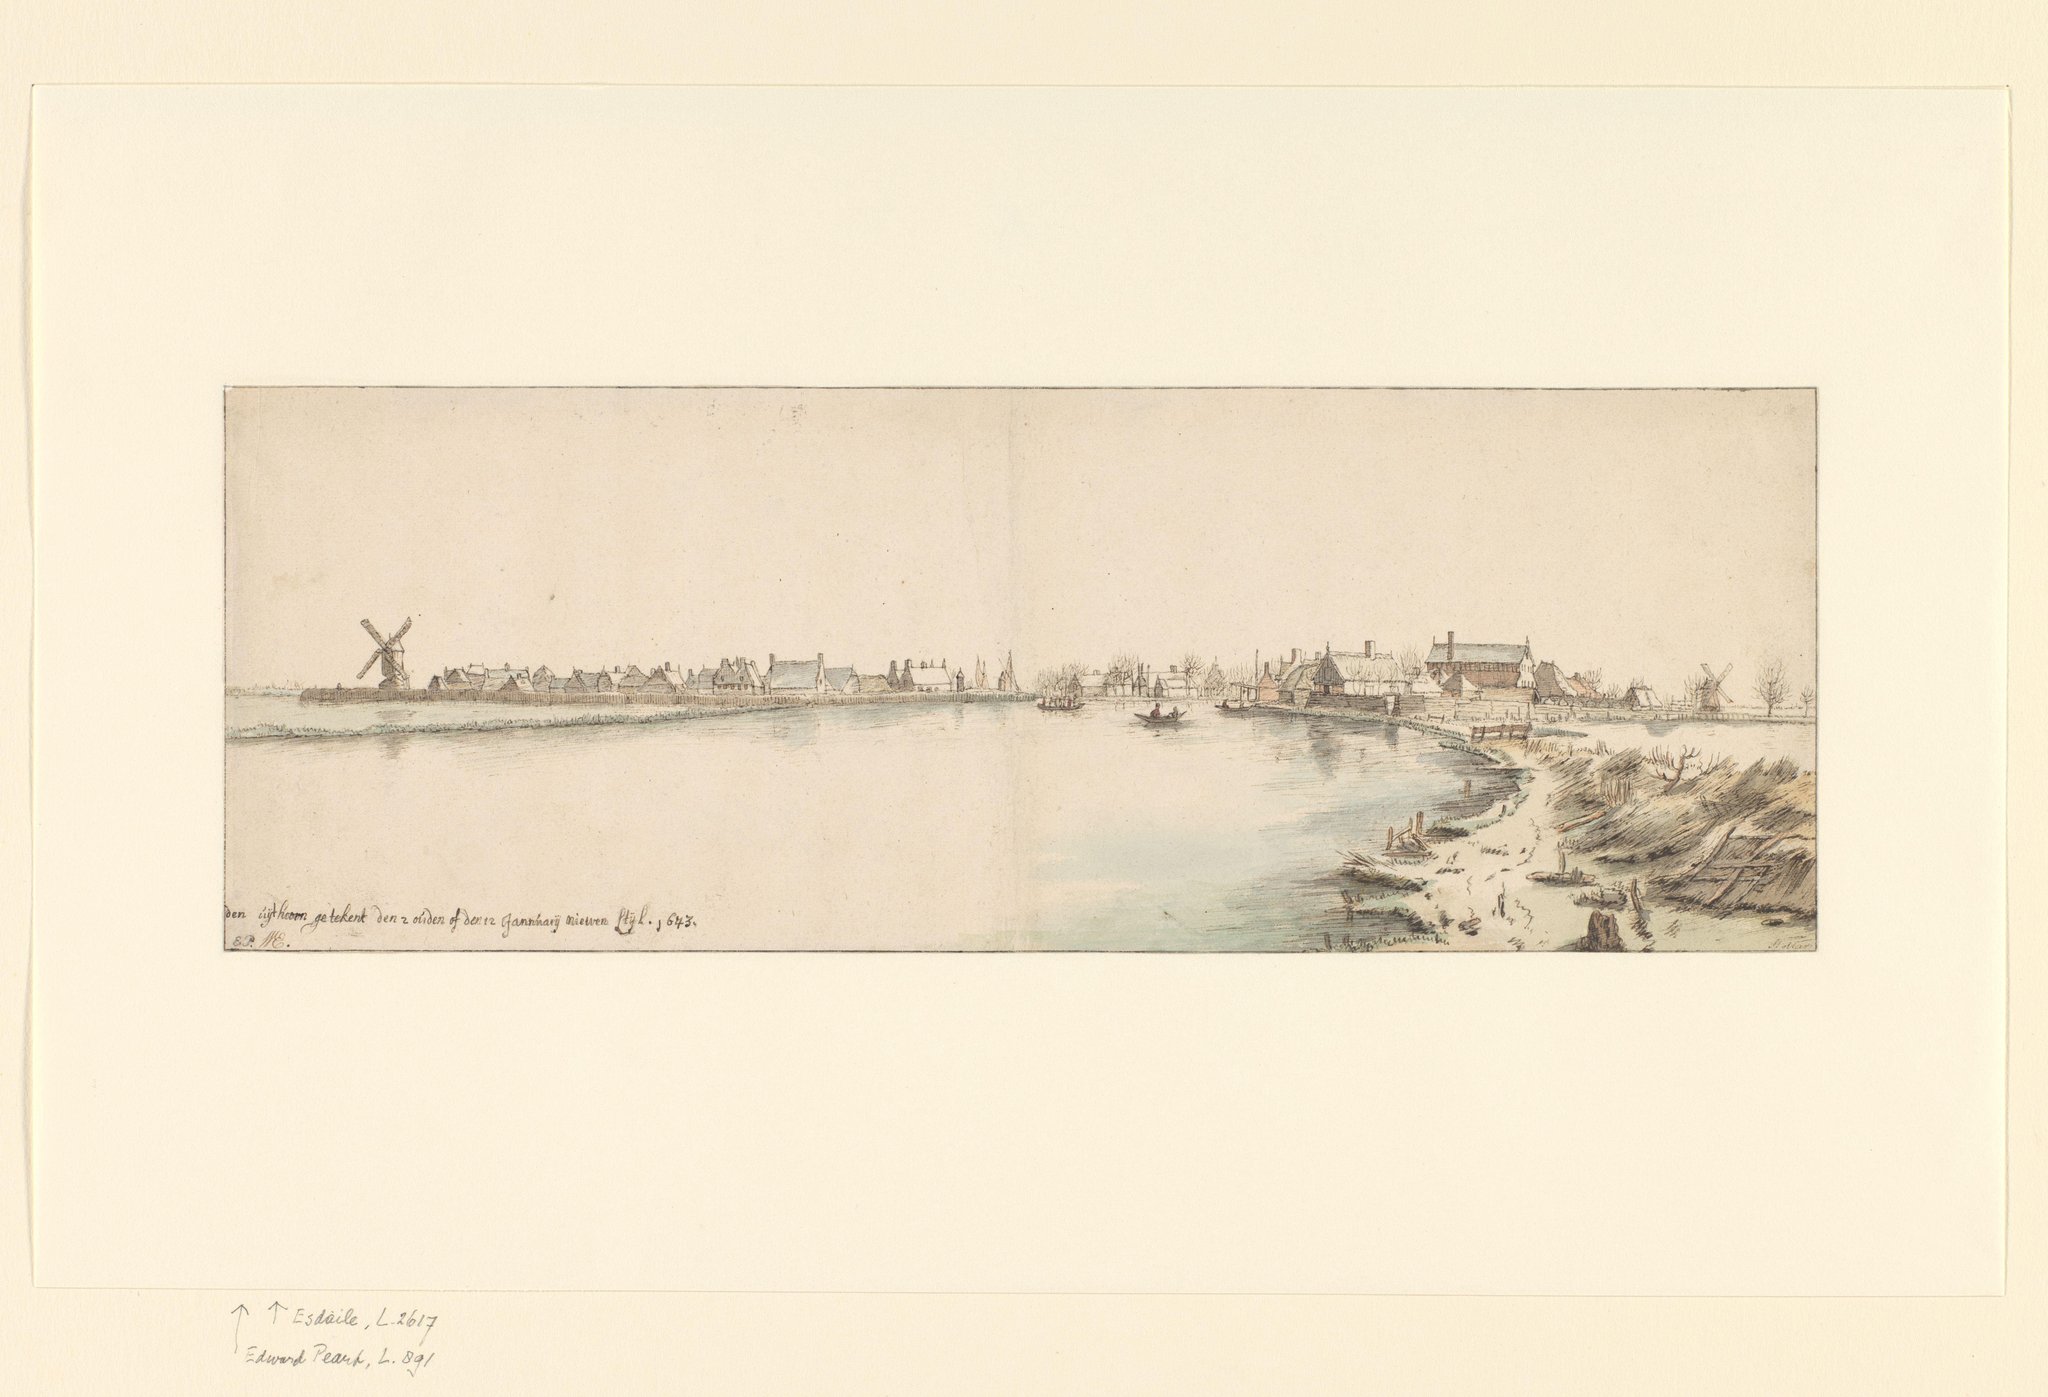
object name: drawing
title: Gezicht op het dorp Uithoorn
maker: valentijn klotz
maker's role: draughtsman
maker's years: 1646-1721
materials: ink, paper, watercolor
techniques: brush, pen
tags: prospect of village, silhouette of village, river